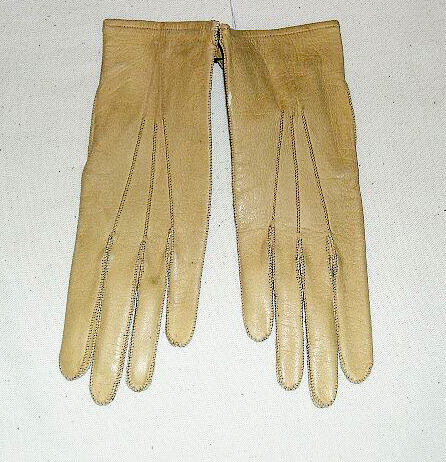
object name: glove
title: Gloves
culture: french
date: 1880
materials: leather